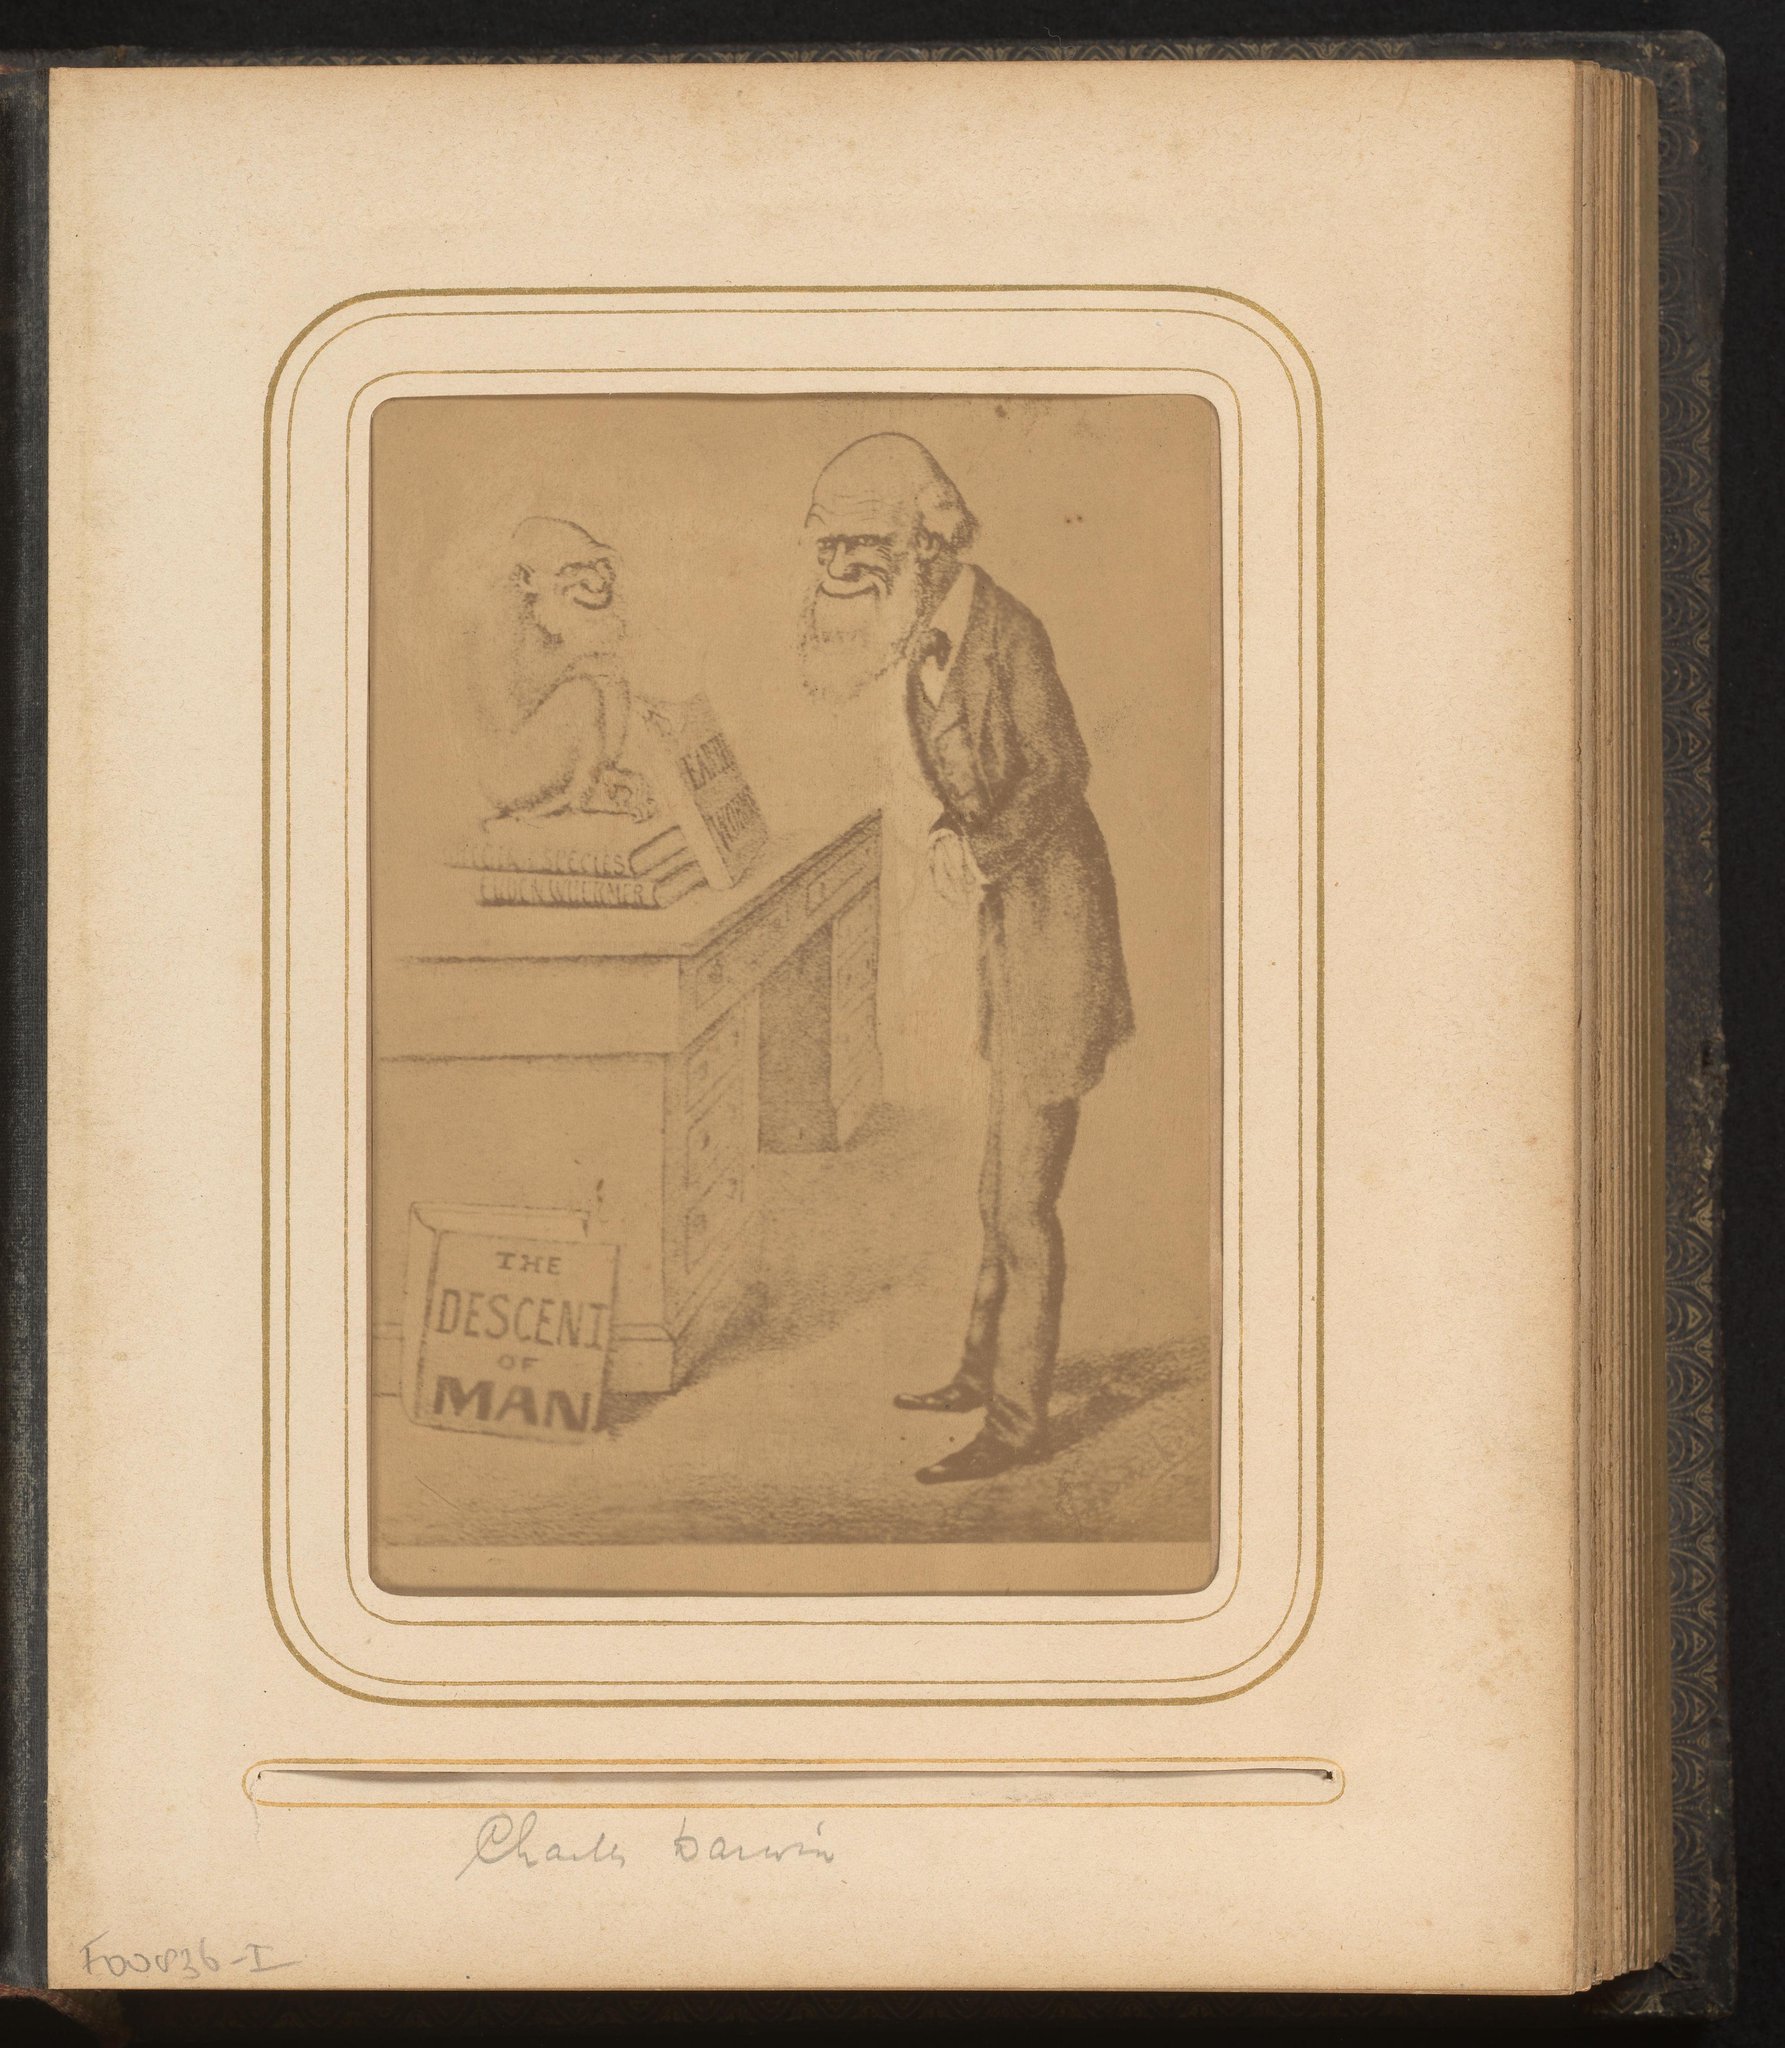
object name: cabinet photograph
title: Fotoreproductie van spotprent: Die Abstammung des Menschen, Darwin gelijkend op een aap op zijn boeken zittend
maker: Anonymous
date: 1872-1890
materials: cardboard, photographic support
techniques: albumen print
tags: charles darwin, monkeys, apes, caricatures (human types)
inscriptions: name: ‘Charles Darwin’, number: ‘10’